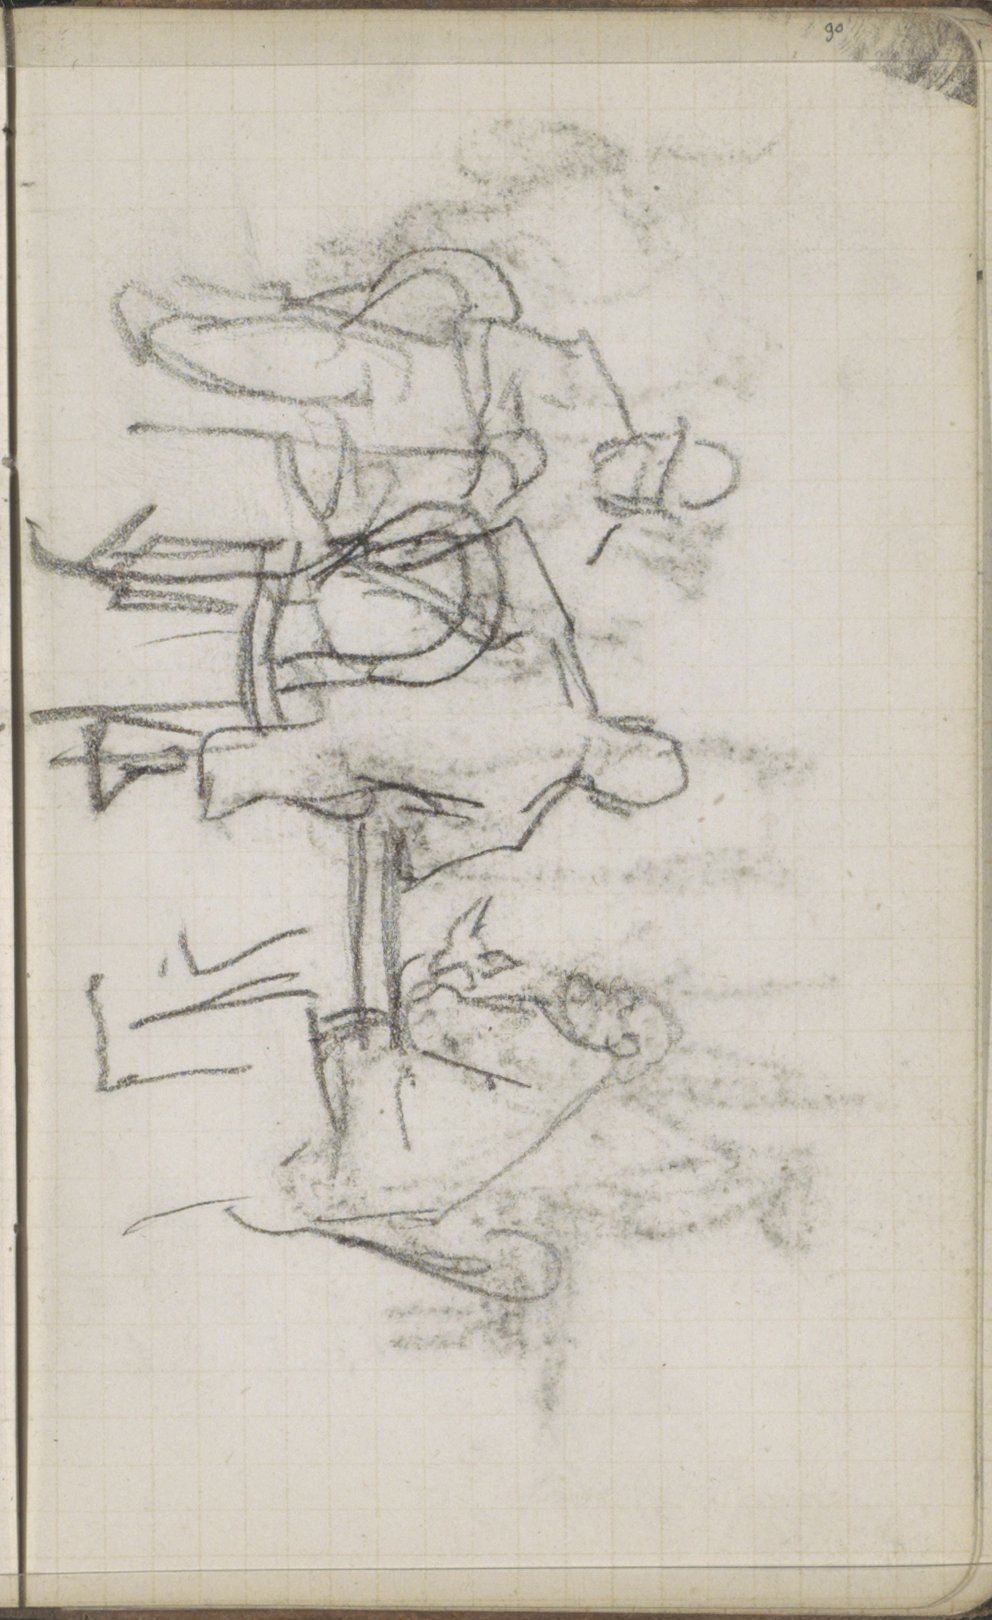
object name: sketchbook leaf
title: Drie mannen aan een cafétafel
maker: marius bauer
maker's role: draughtsman, print maker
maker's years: 1867-1932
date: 1879-1885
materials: chalk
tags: sitting figure, adult man, inn, coffee-house, public house, etc., head-gear: top hat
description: Pagina 90 uit een schetsboek met 58 bladen.